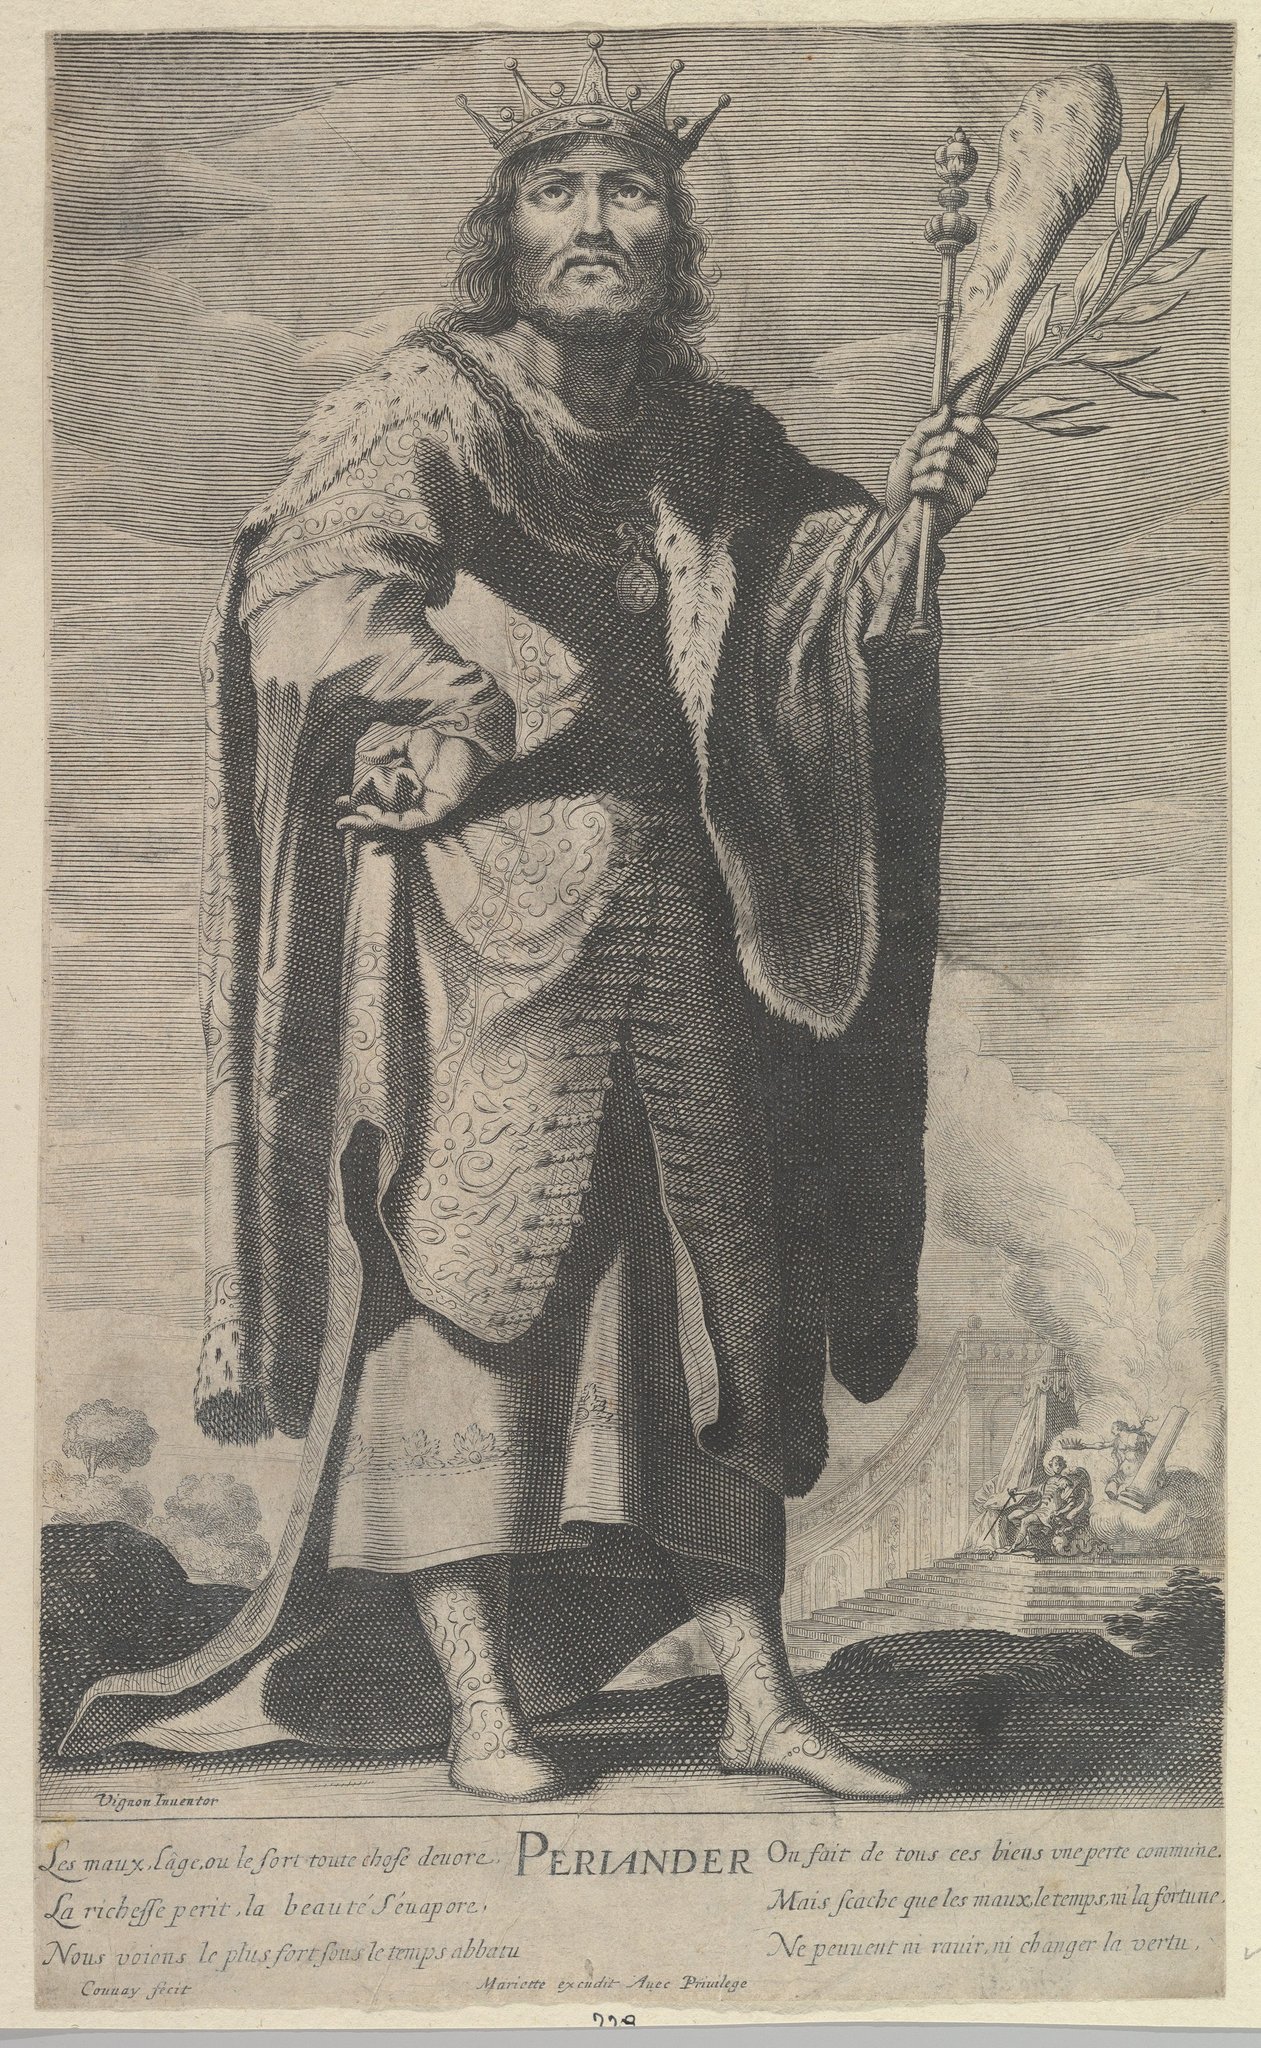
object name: print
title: Périandre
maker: jean couvay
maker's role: artist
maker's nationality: french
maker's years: 1600-1663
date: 1639-1640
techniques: engraving, etching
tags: men